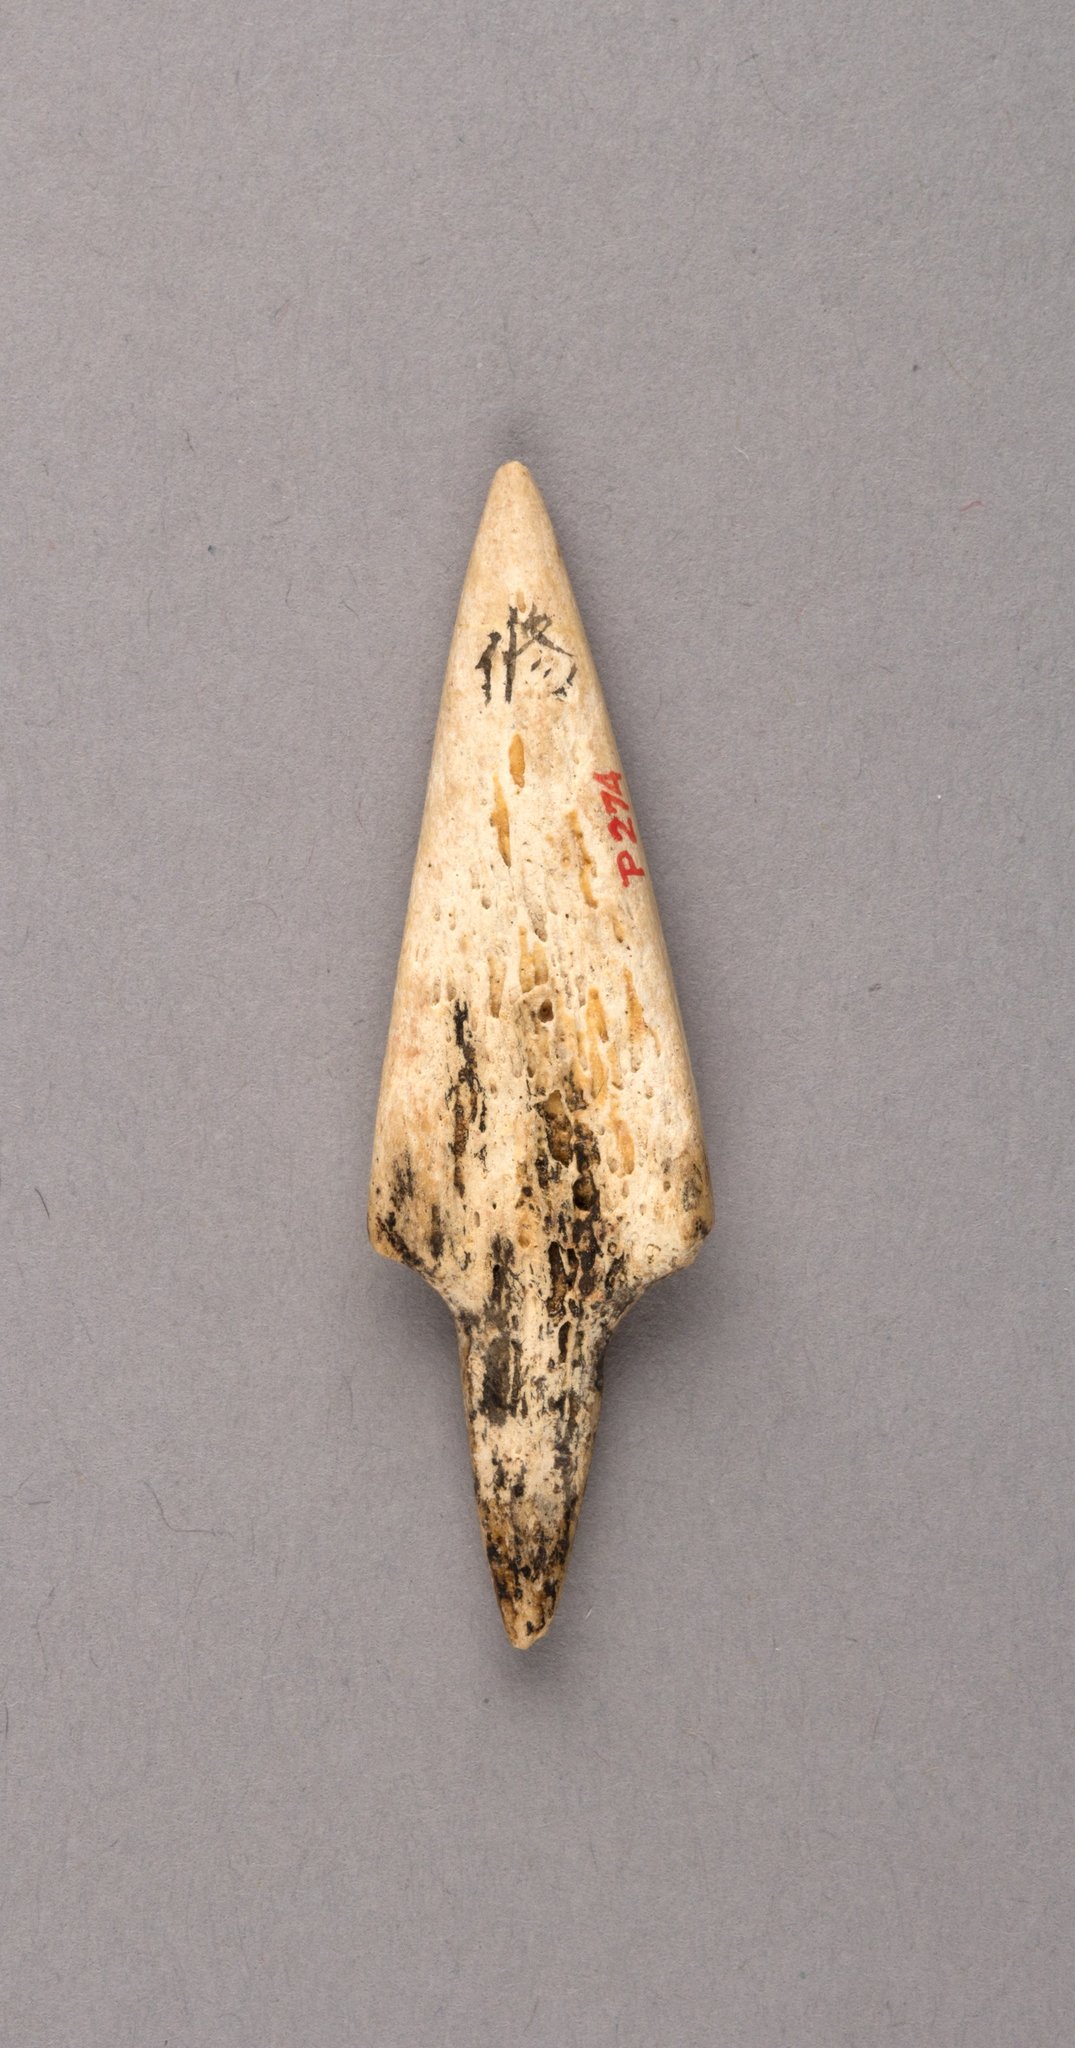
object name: arrowhead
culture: japanese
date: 1000-300 BCE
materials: bone